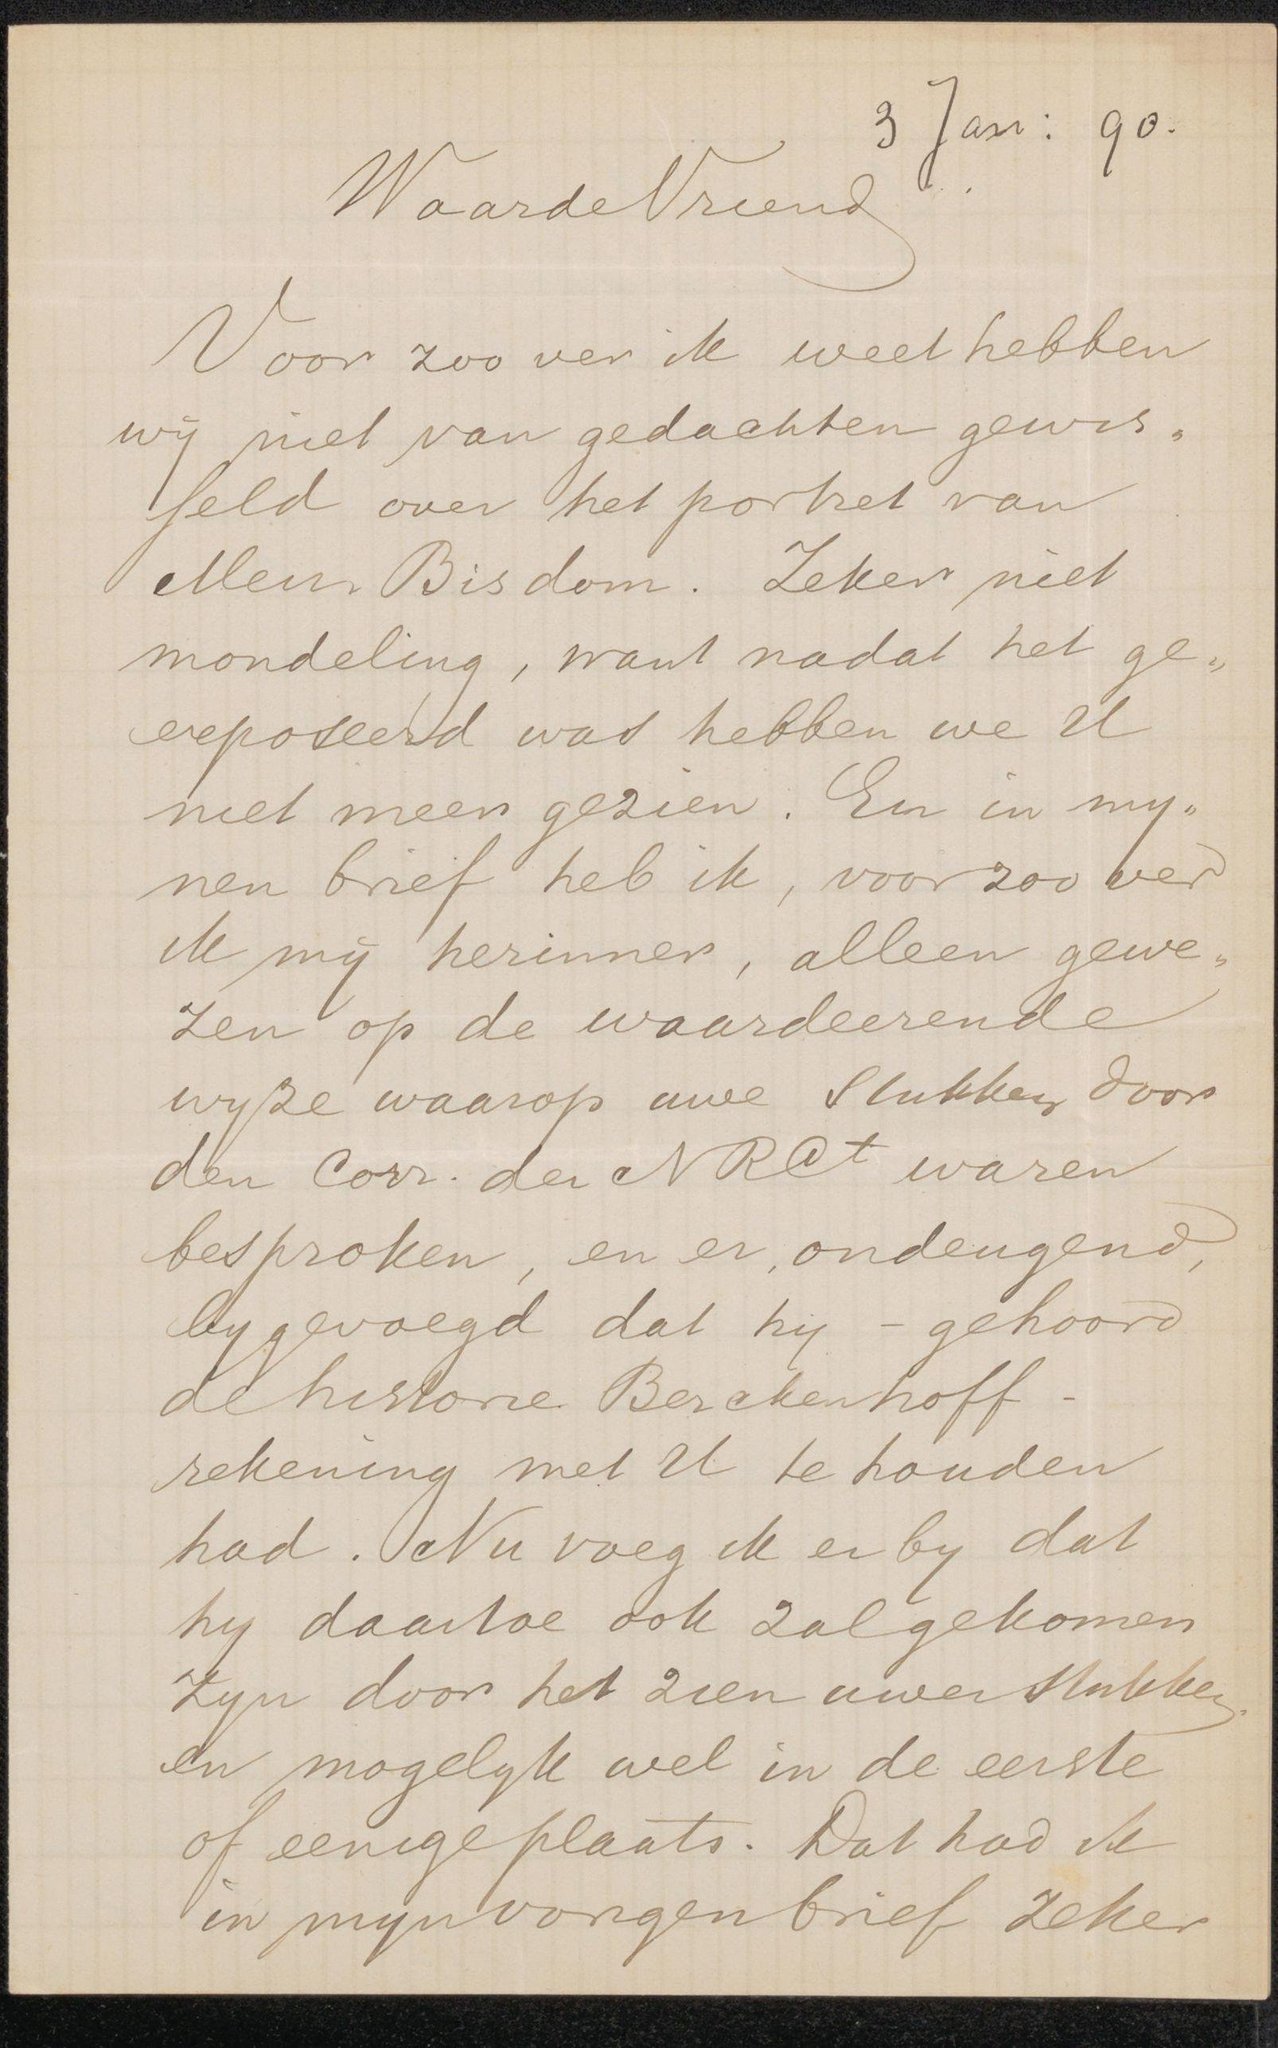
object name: letter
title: Brief aan Jan Veth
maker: martinus cornelis lebret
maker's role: verzamelaar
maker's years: 1833-1894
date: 1874-1894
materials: ink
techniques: pen, writing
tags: dordrecht, painter, print maker, draughtsman, designer, jan veth, allard pierson, h.l. berckenhoff, historical persons (portraits and scenes from the life)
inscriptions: collector's mark: ‘RPK’